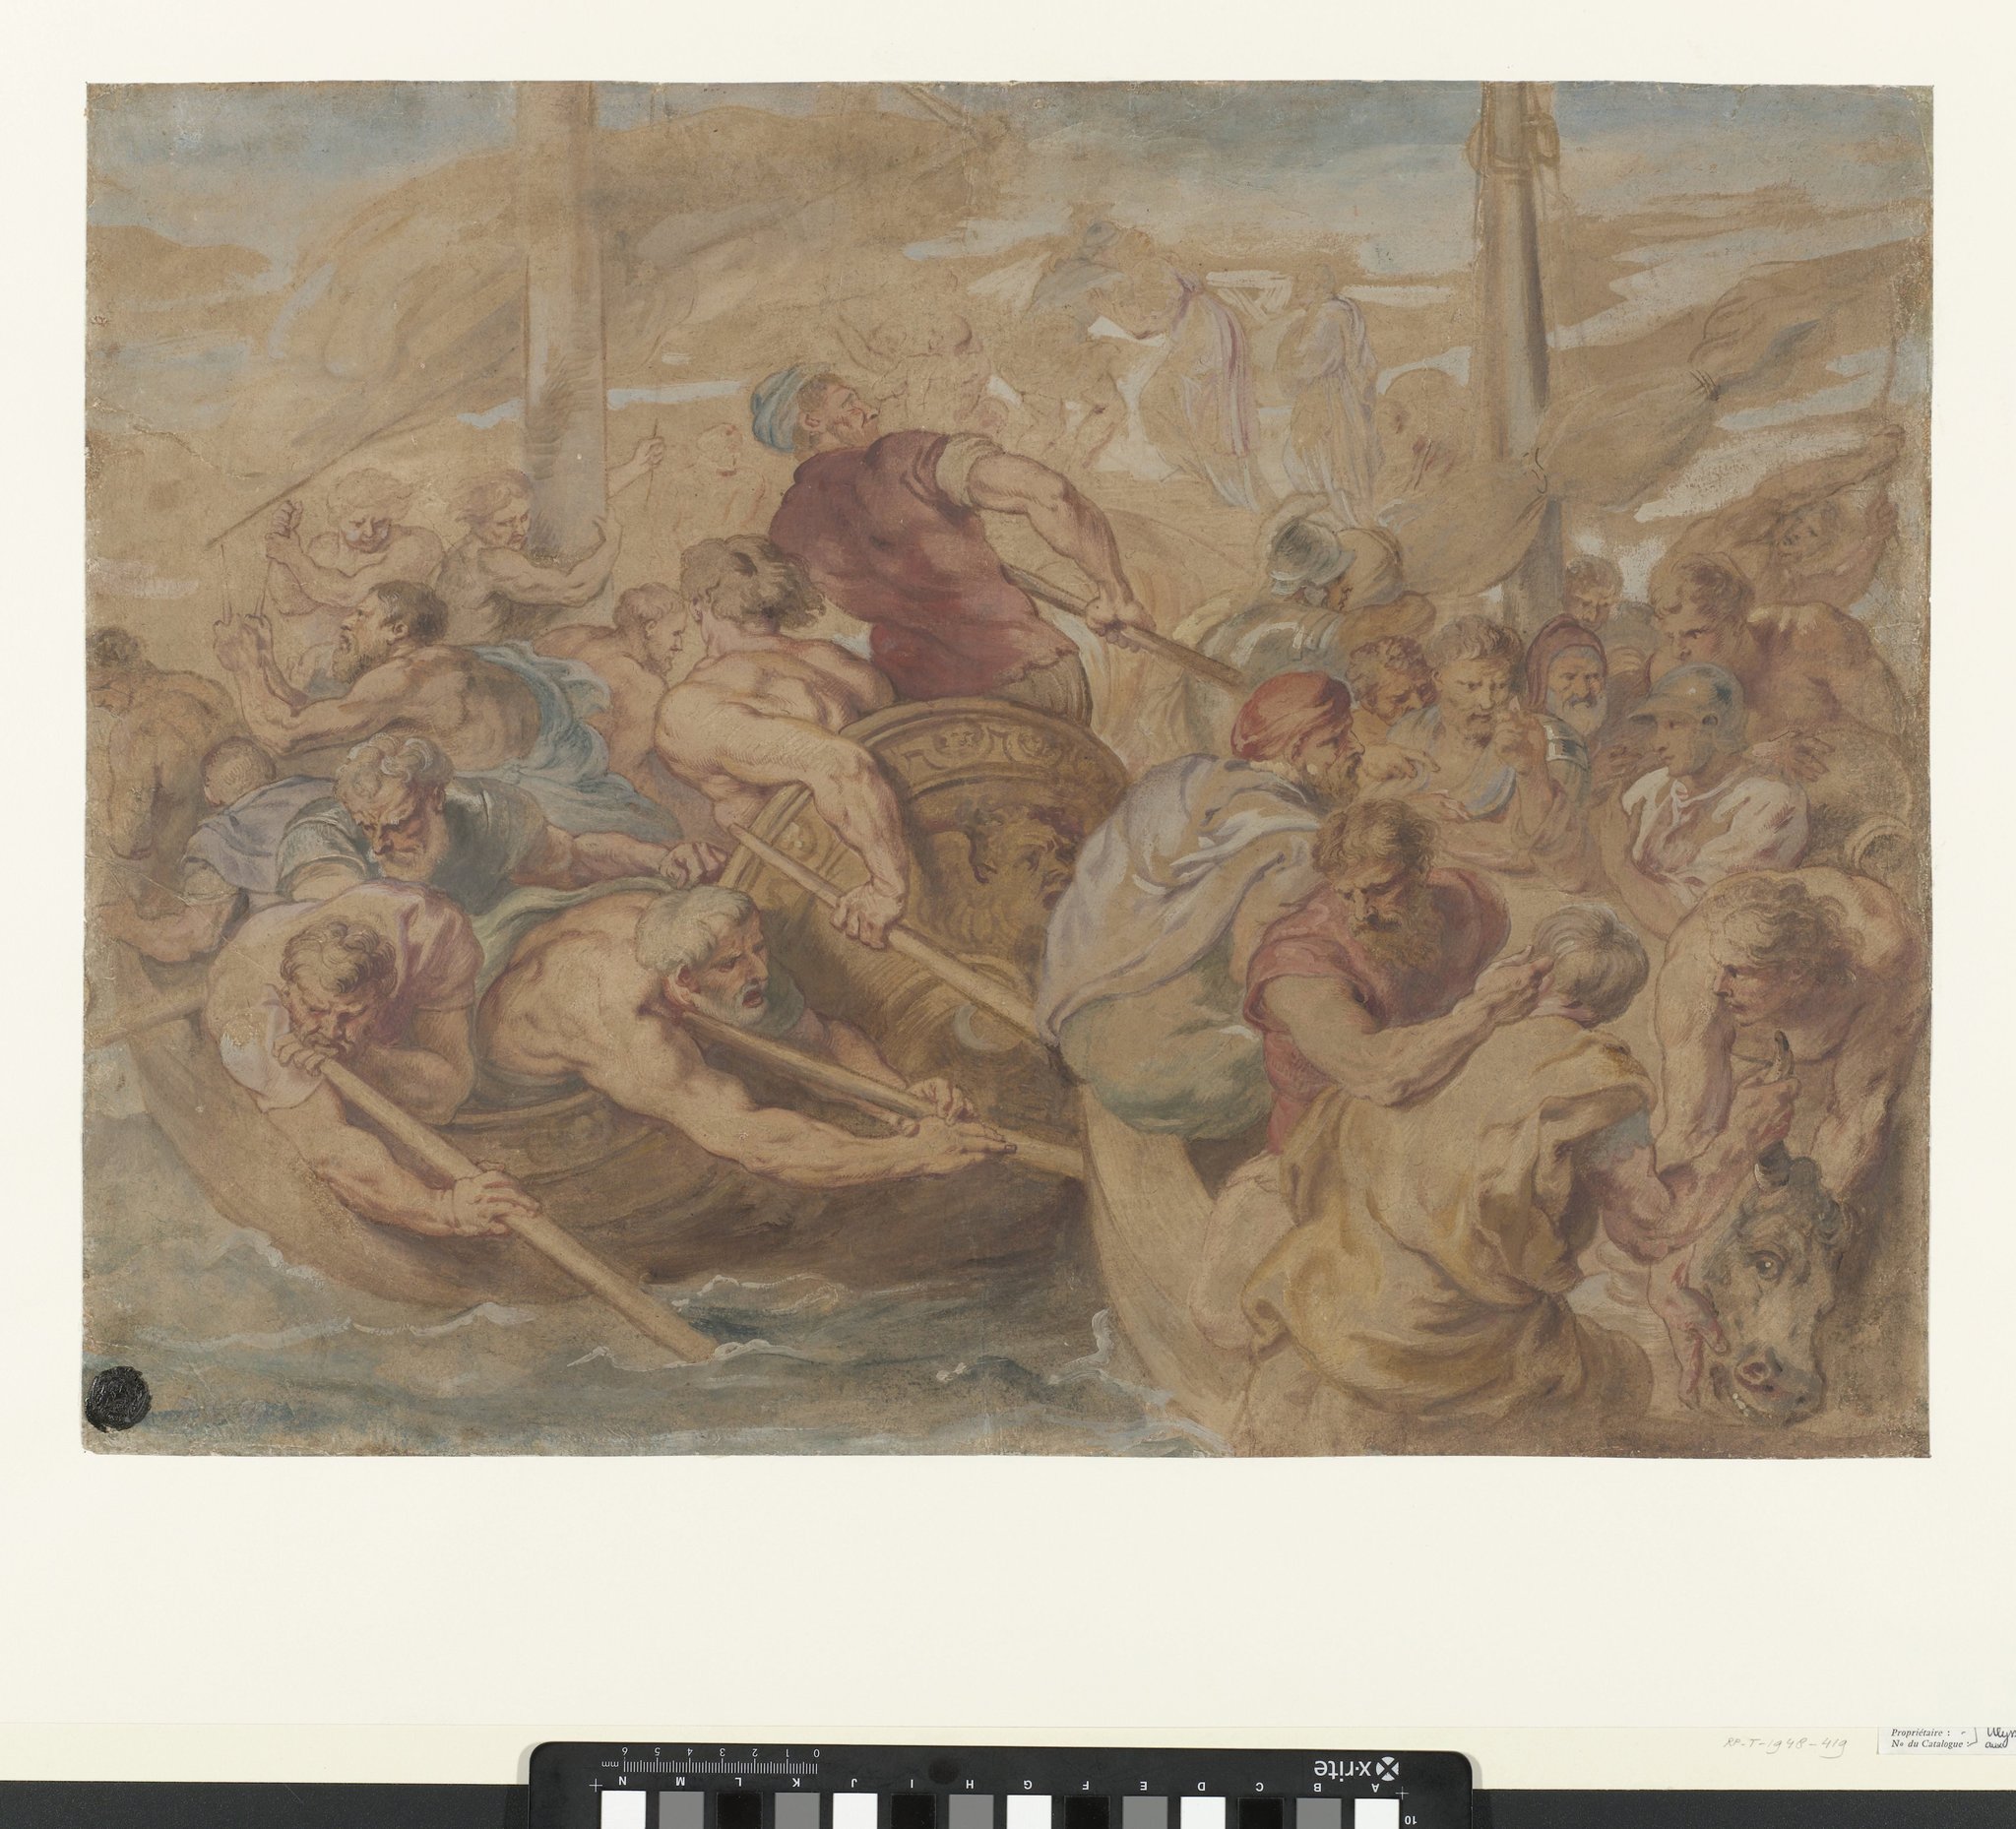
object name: drawing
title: Drie gecombineerde episoden uit de geschiedenis van Odysseus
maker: peter paul rubens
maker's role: draughtsman, painter, print maker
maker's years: 1577-1640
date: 1587-1640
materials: oil, paper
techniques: brush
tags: ulysses, tied to the mast of his ship, passes the sirens, in thrinacria ulysses' men devour some of the cattle of the sun-god while ulysses is asleep